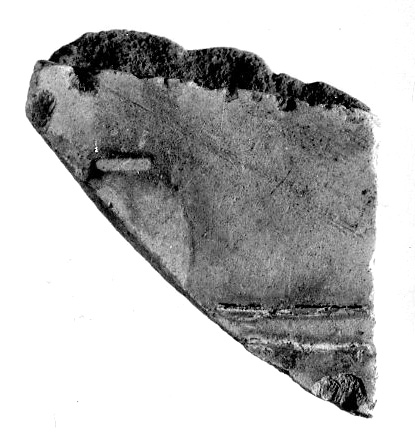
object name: relief fragment, tomb of meketre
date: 1981-1975 BCE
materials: limestone, paint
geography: egypt